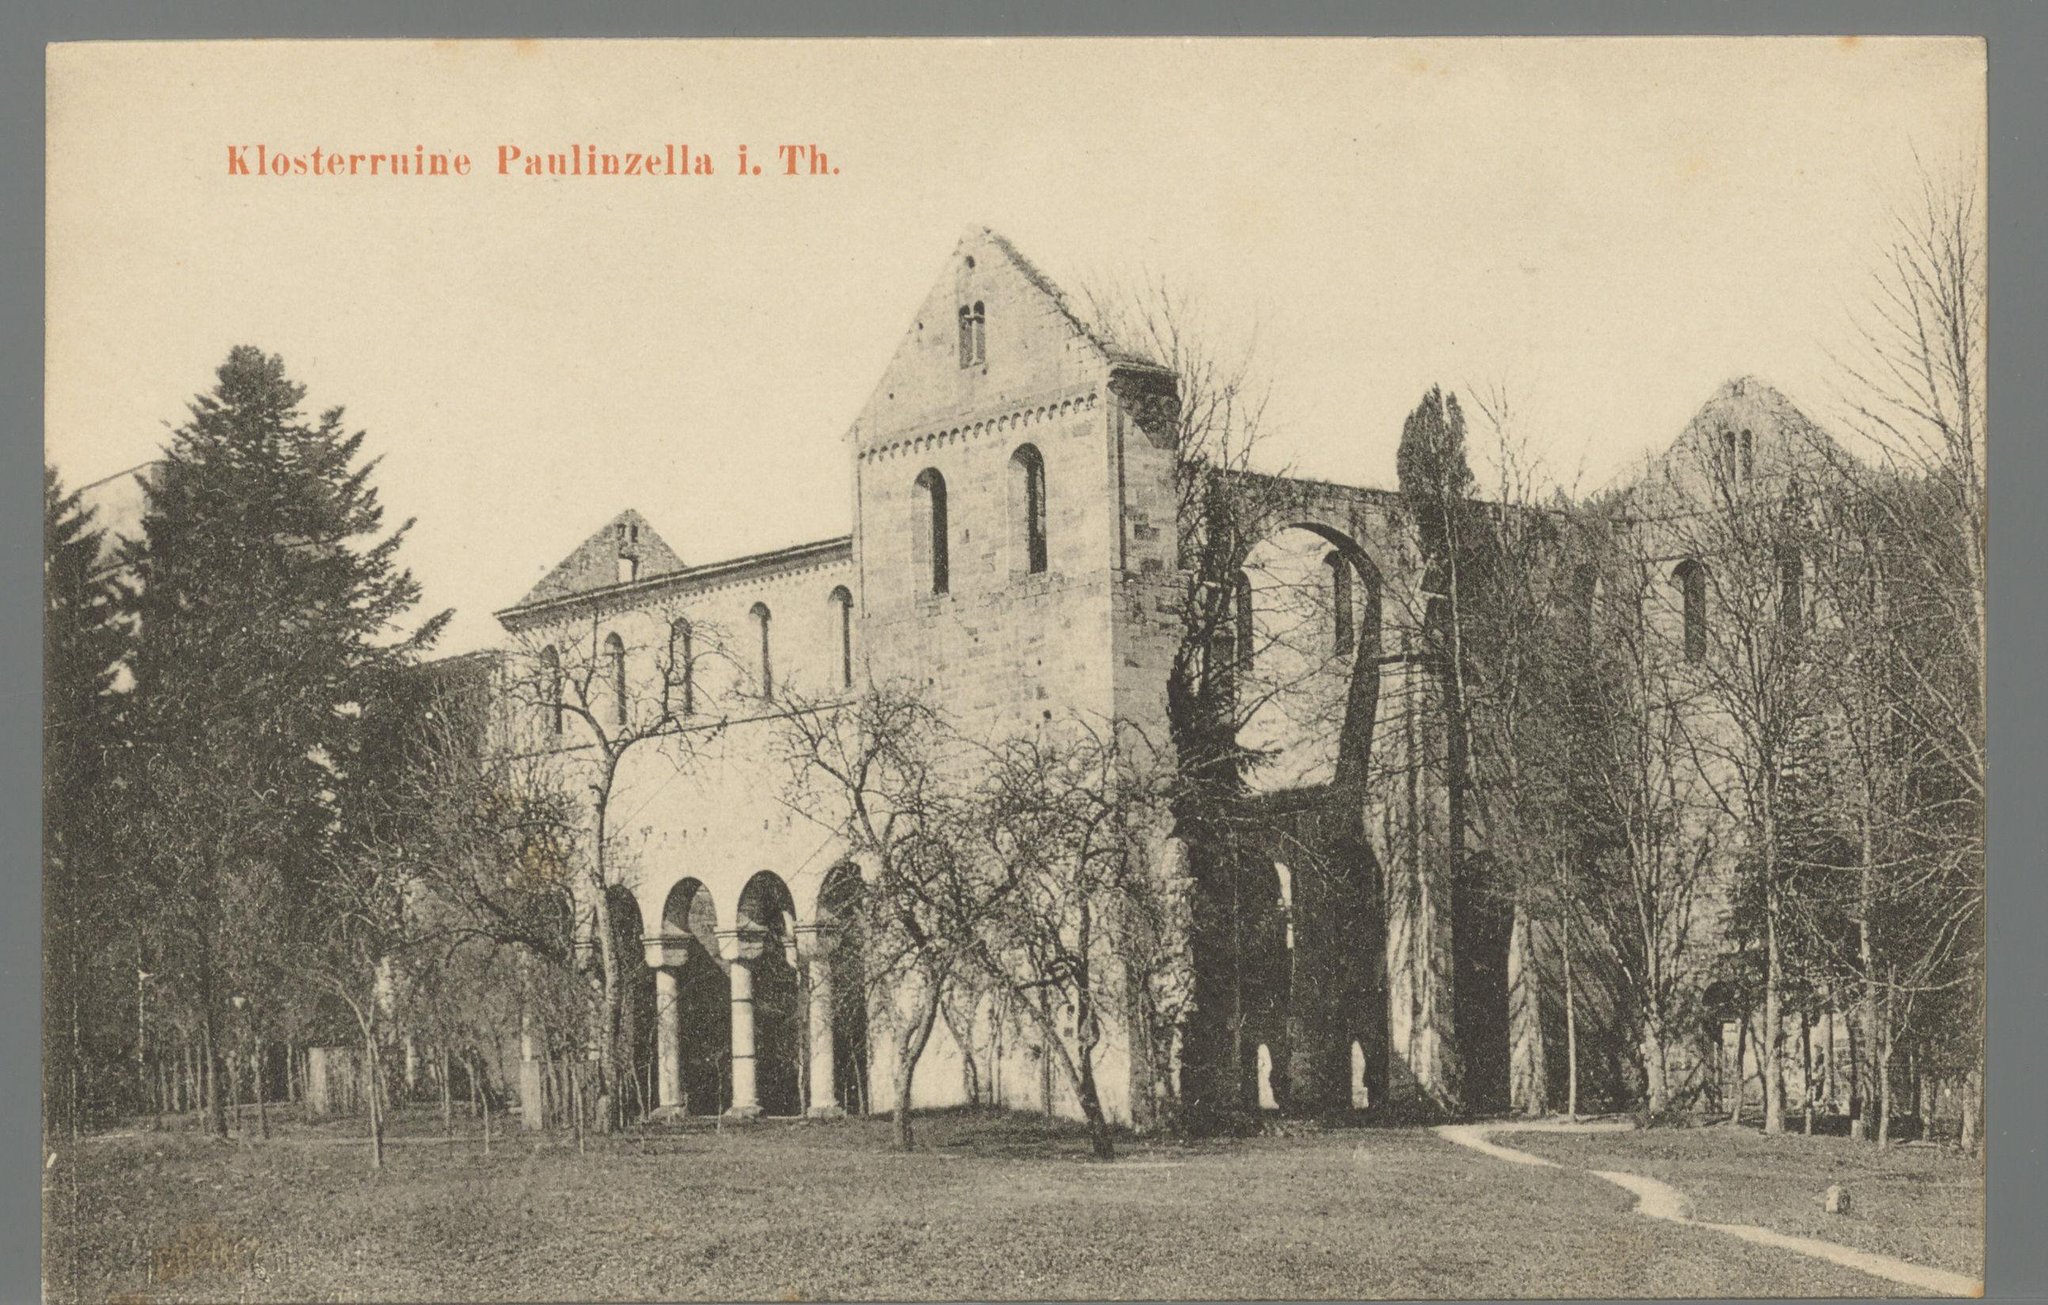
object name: photomechanical print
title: Klosterruine Paulinzella i. Th.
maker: Anonymous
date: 1905-1909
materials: cardboard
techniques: photograph, writing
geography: trier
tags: ruin of church, monastery, etc.